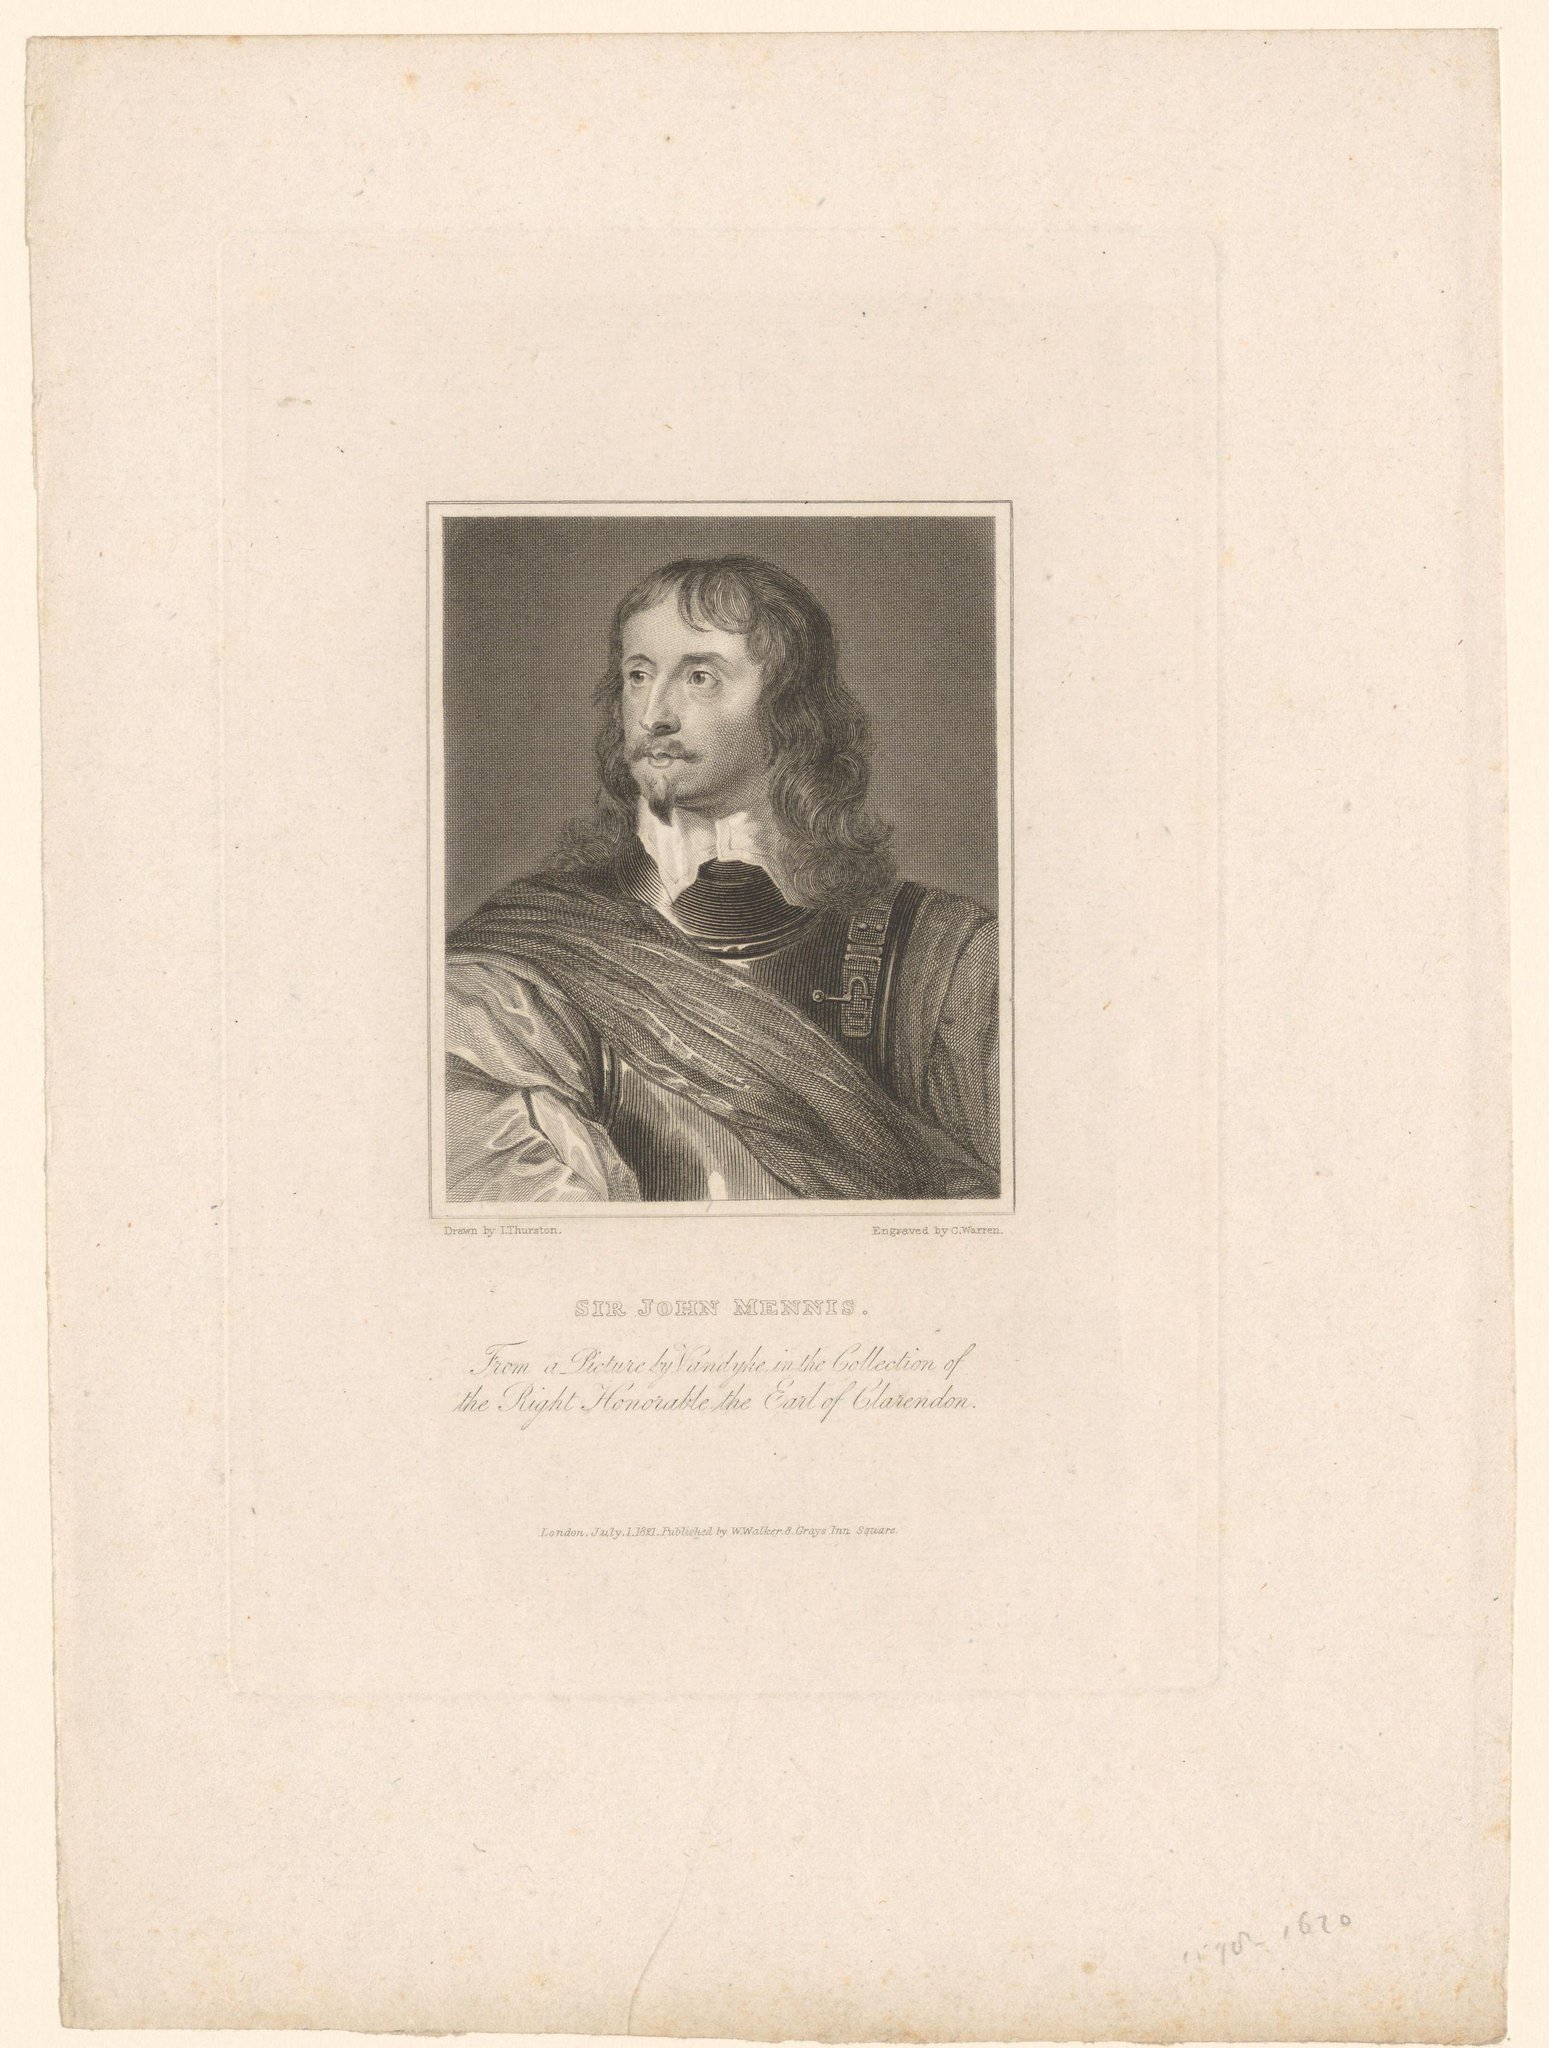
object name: print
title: Portret van John Mennis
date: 1821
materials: paper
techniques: engraving, etching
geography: london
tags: historical persons, commander-in-chief, admiral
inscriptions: collector's mark: Lugt 2228